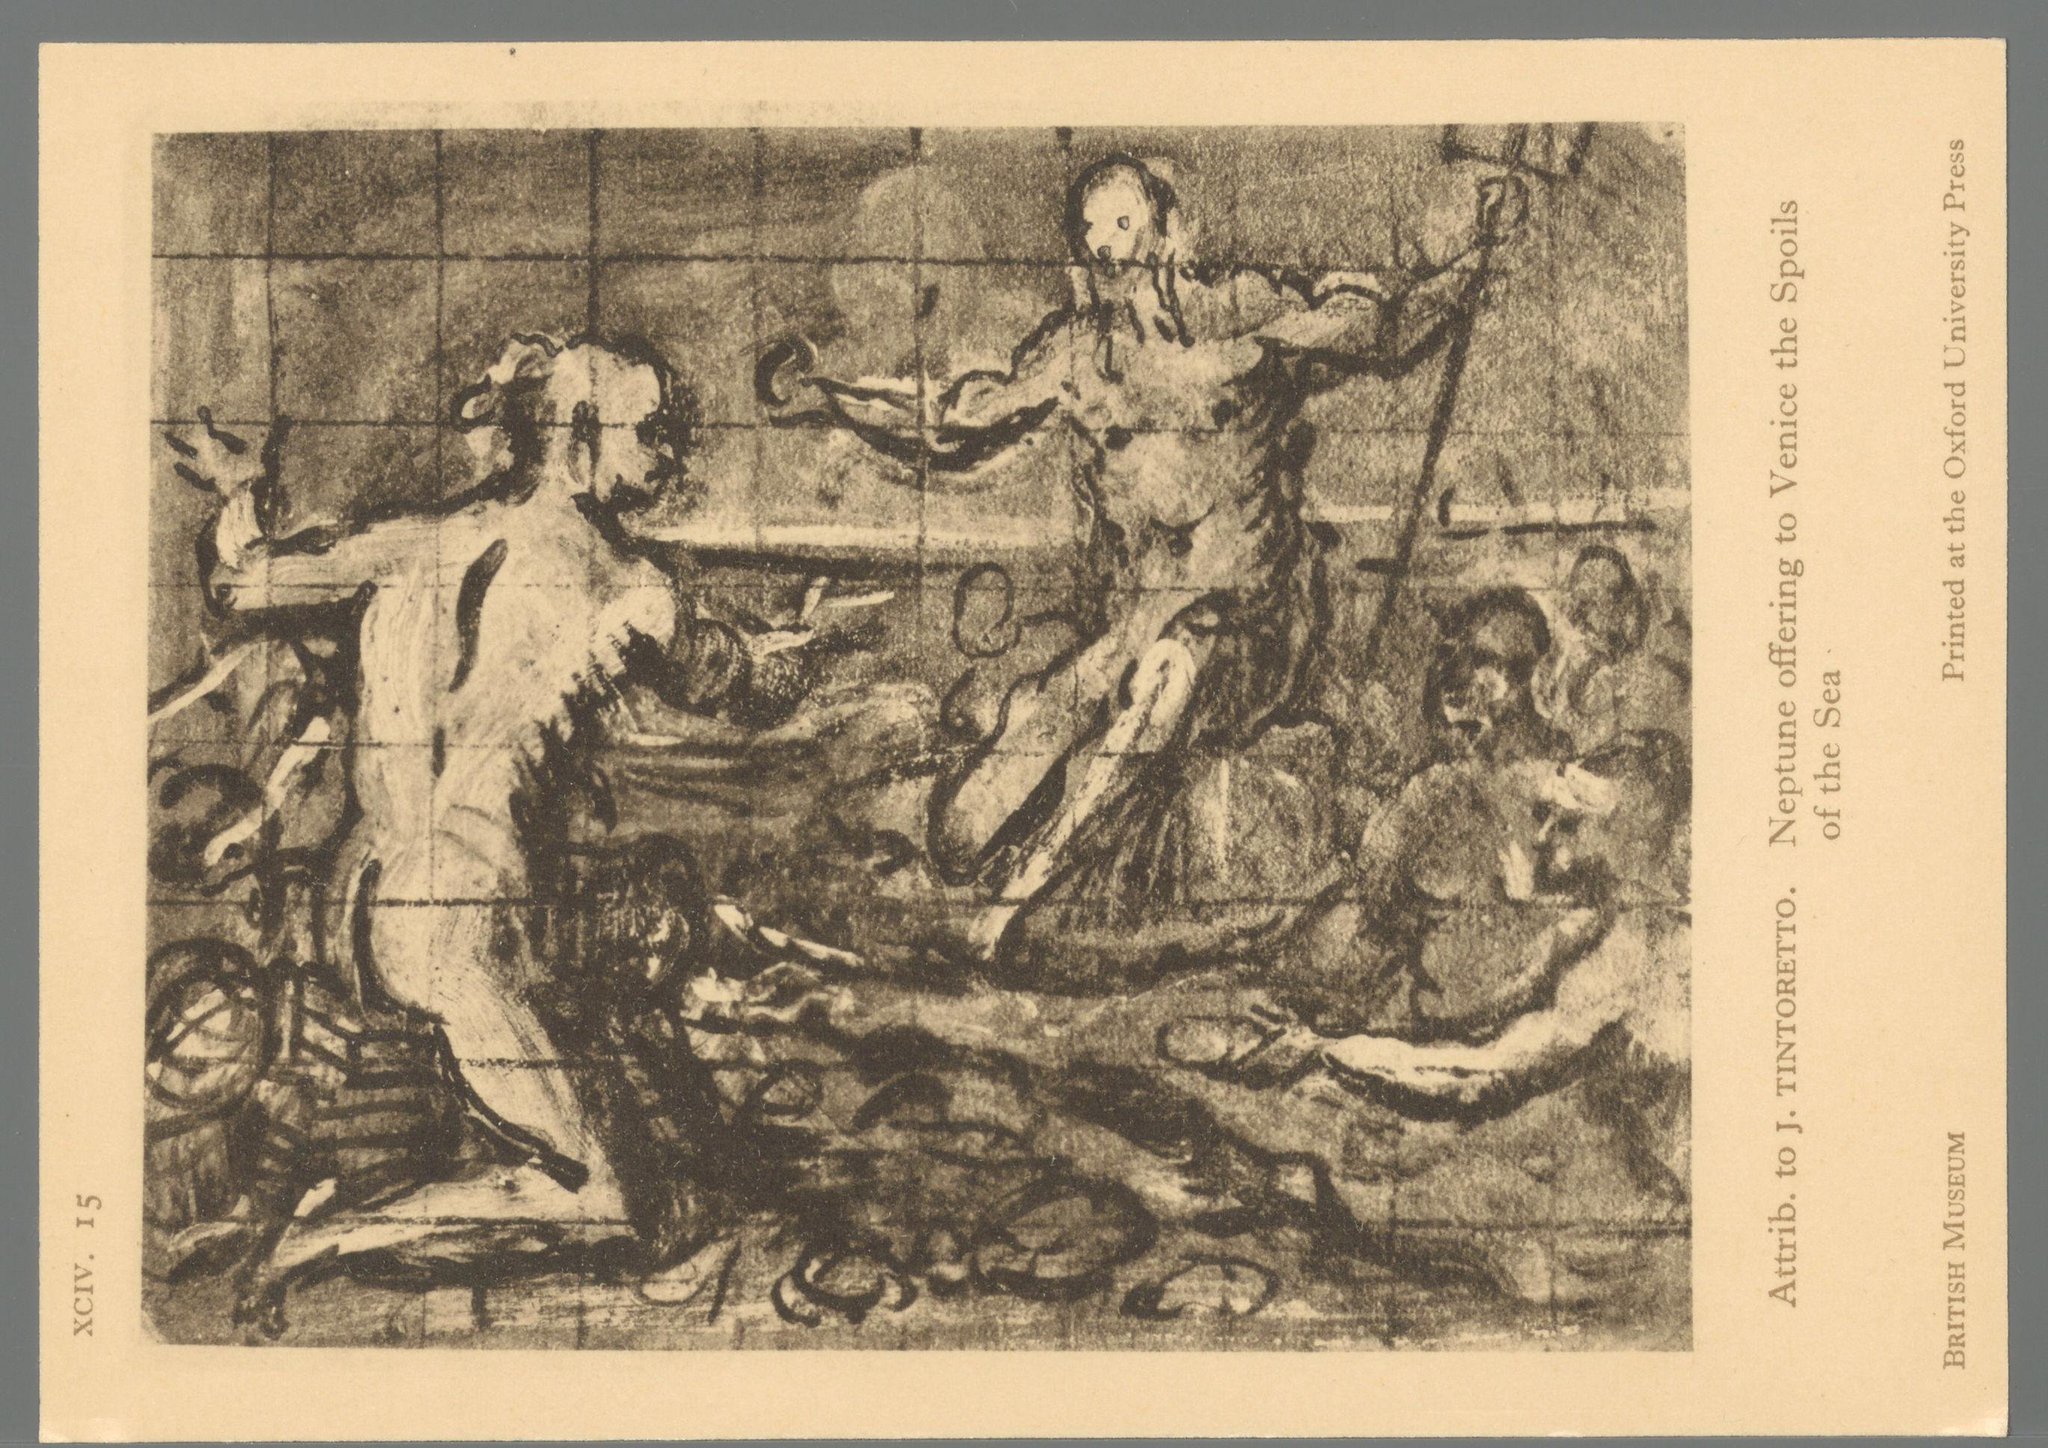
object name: photomechanical print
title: Attrib. to J. Tintoretto. Neptune offering to Venice the Spoils of the Sea. British Museum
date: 1902-1950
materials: cardboard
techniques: photograph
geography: oxford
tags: drawing, sketch, permanent exhibition, museum